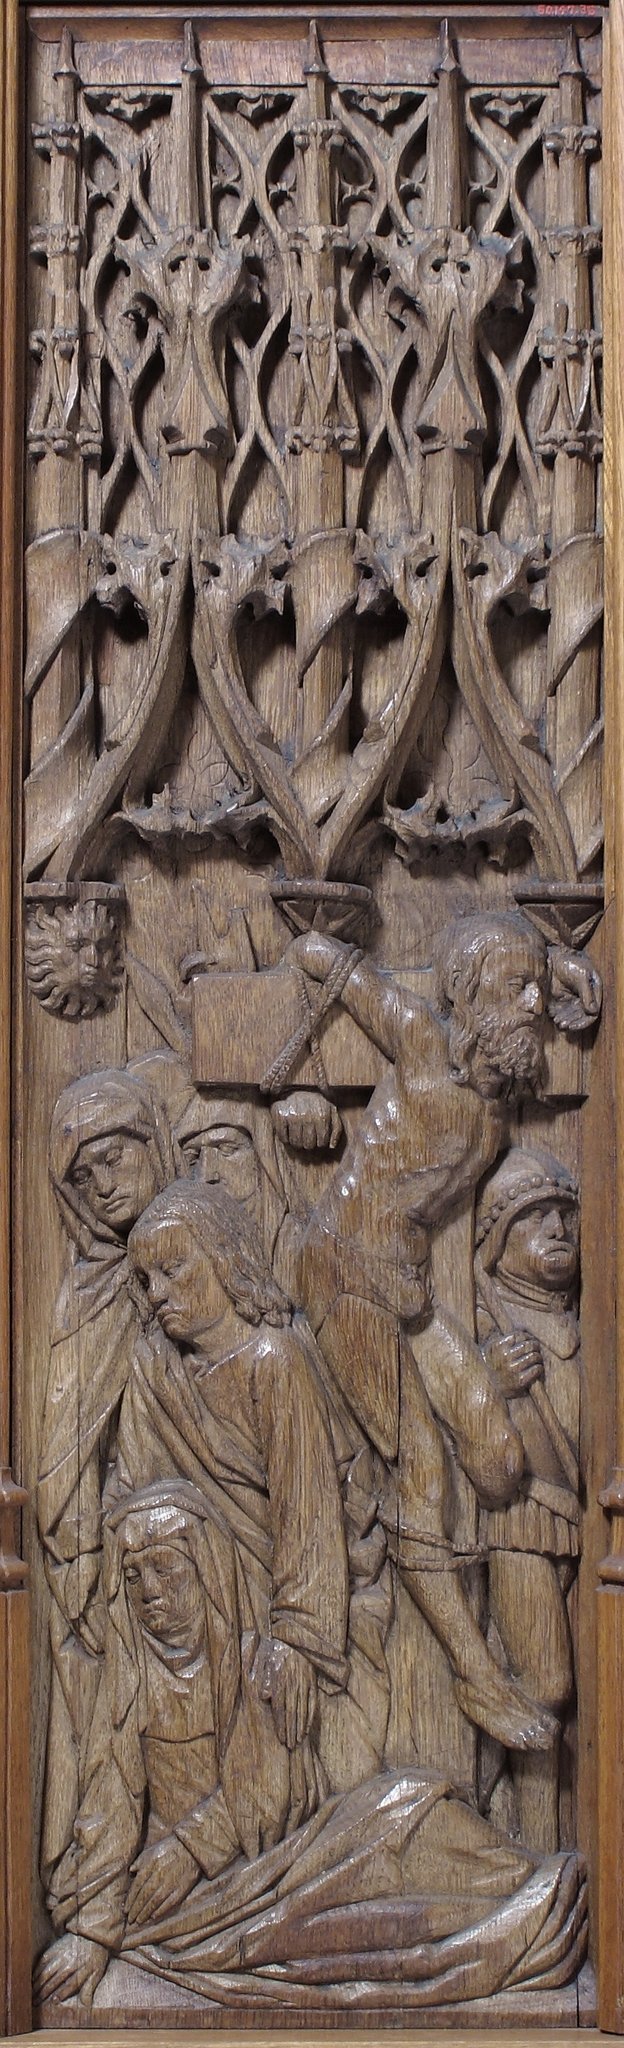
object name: panel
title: Panel with the Crucifixion of the Good Thief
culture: french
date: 1501-1533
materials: wood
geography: france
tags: men,women,christ,crucifixion